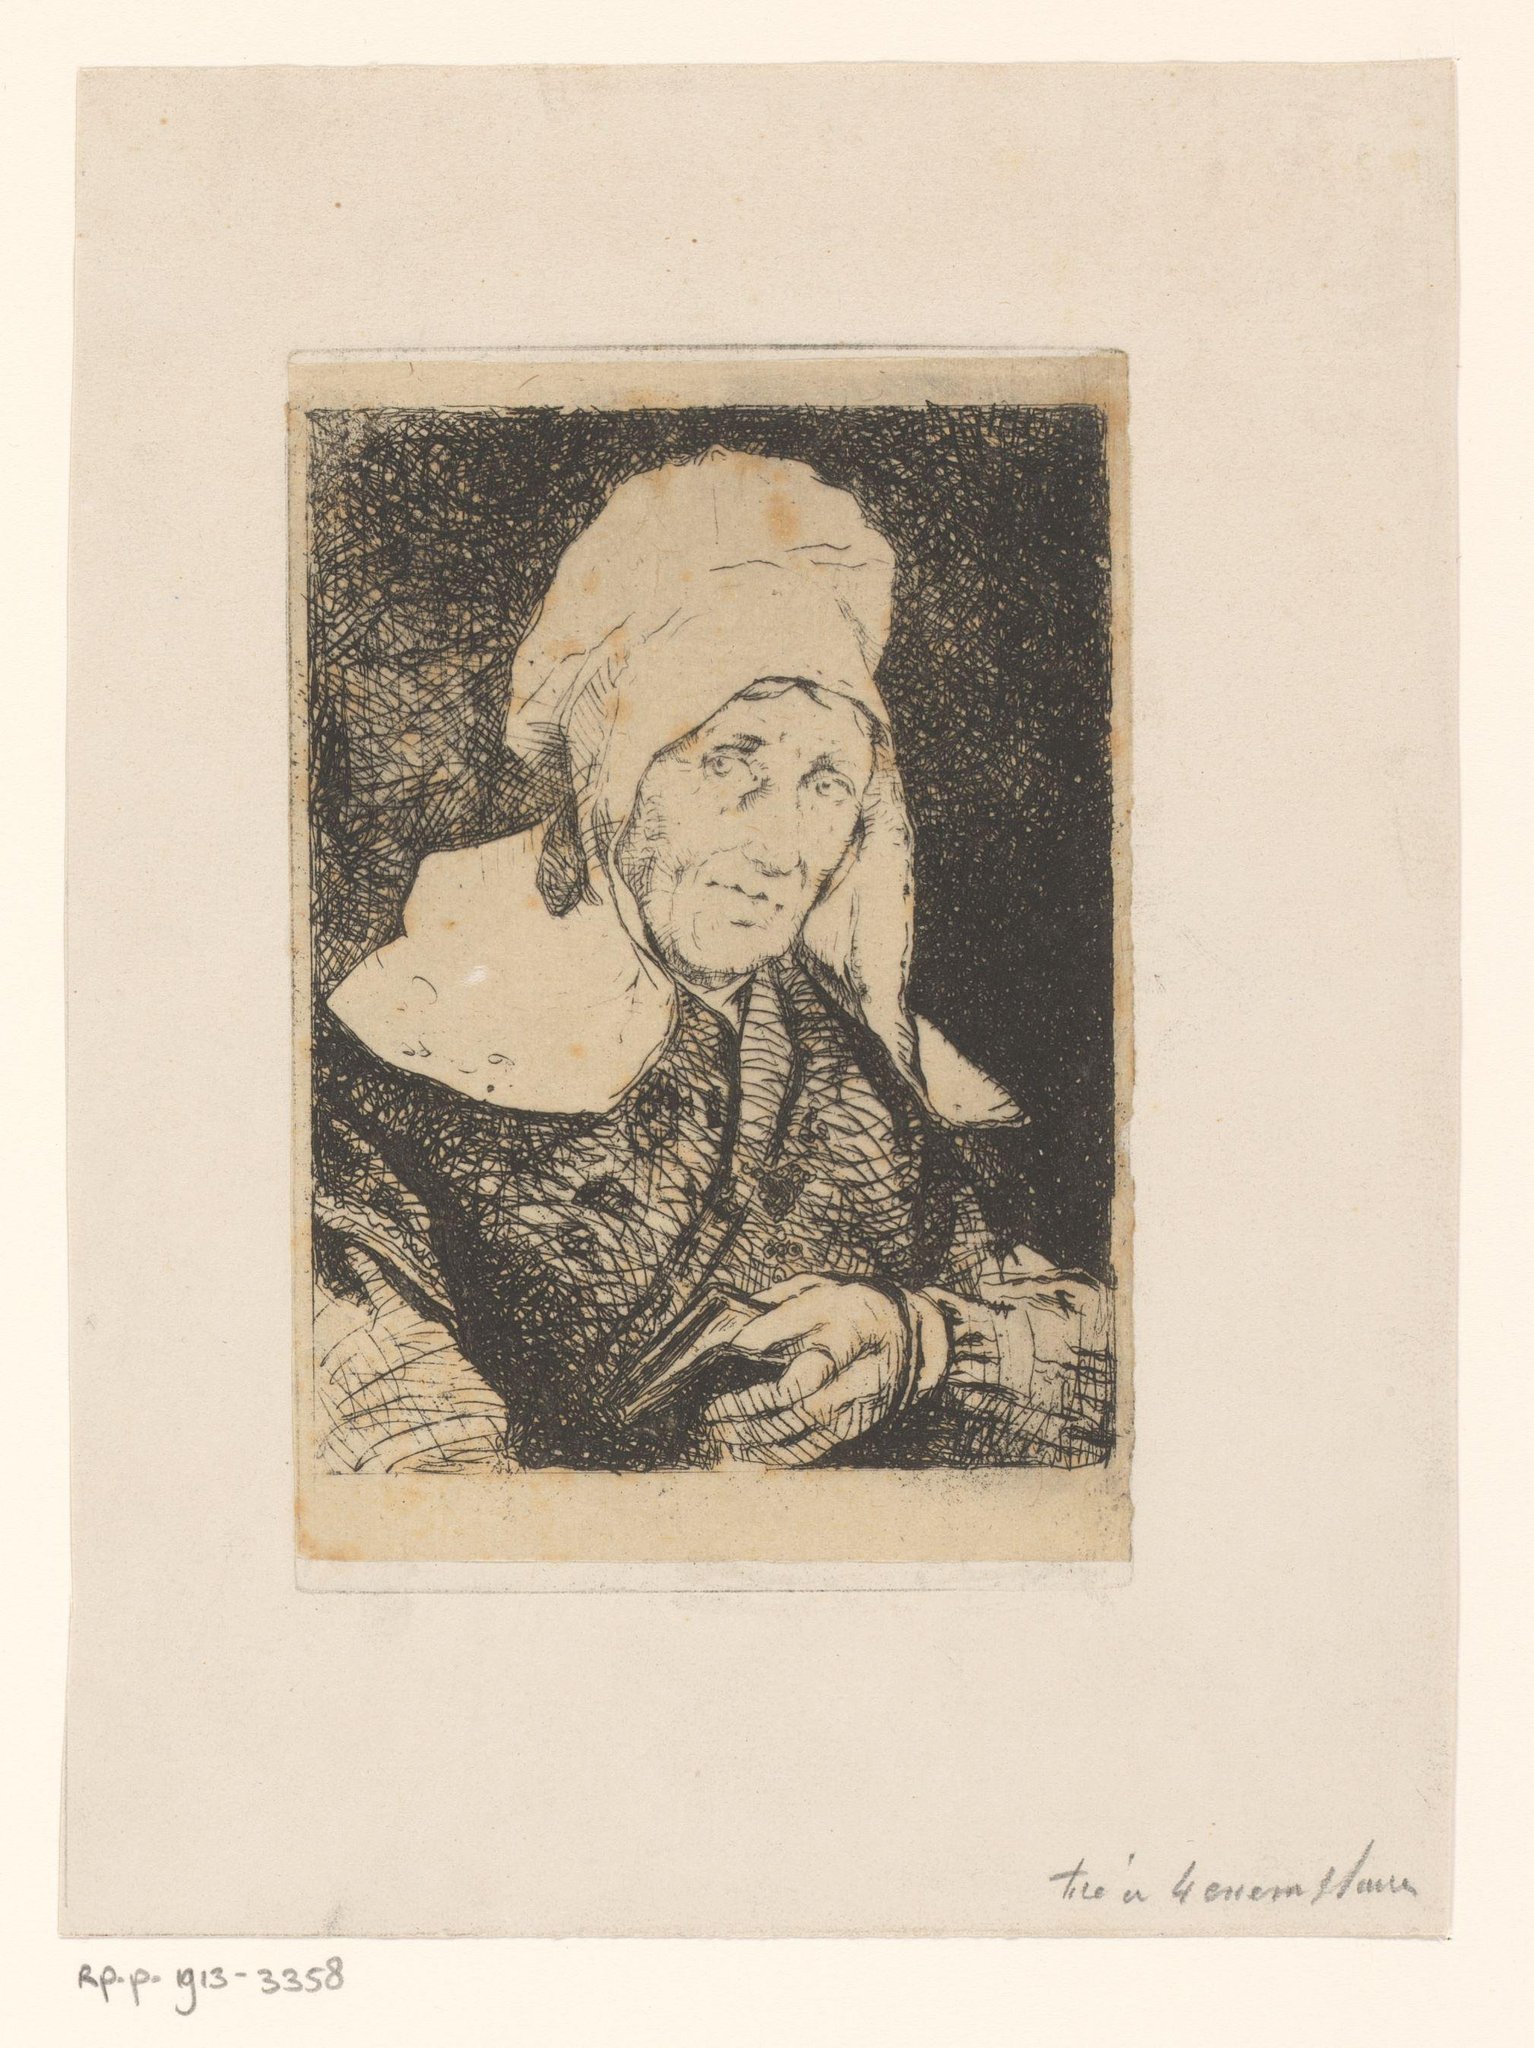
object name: print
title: Hoofd van een oude vrouw met muts en een boek in haar hand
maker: piet verhaert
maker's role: print maker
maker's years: 1852-1908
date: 1862-1908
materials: paper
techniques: etching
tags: head-gear, old woman, book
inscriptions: inscription: ‘Tire à 4 exemplaire’, collector's mark: Lugt 2228